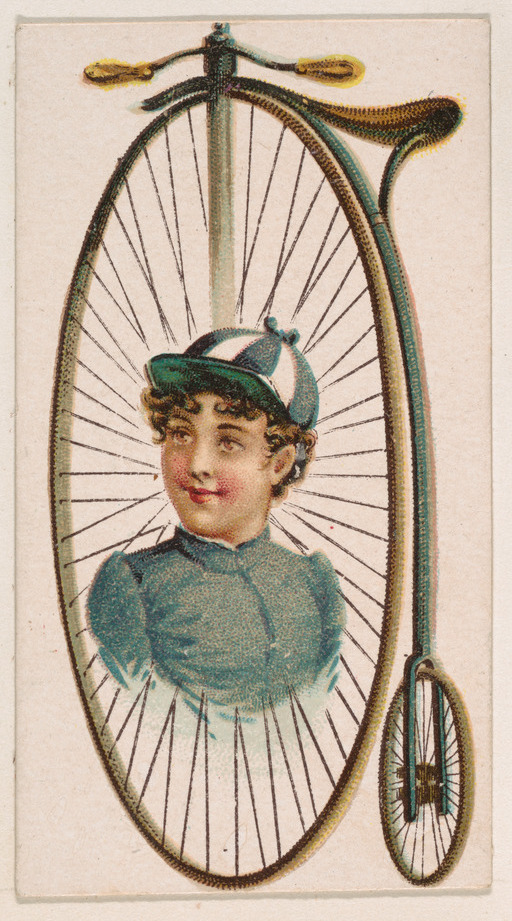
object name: print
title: Bicycle, from the Novelties series (N228, Type 5) issued by Kinney Bros.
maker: kinney brothers tobacco company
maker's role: publisher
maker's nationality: american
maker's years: 1869-2011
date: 1889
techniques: color lithograph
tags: women,bicycles